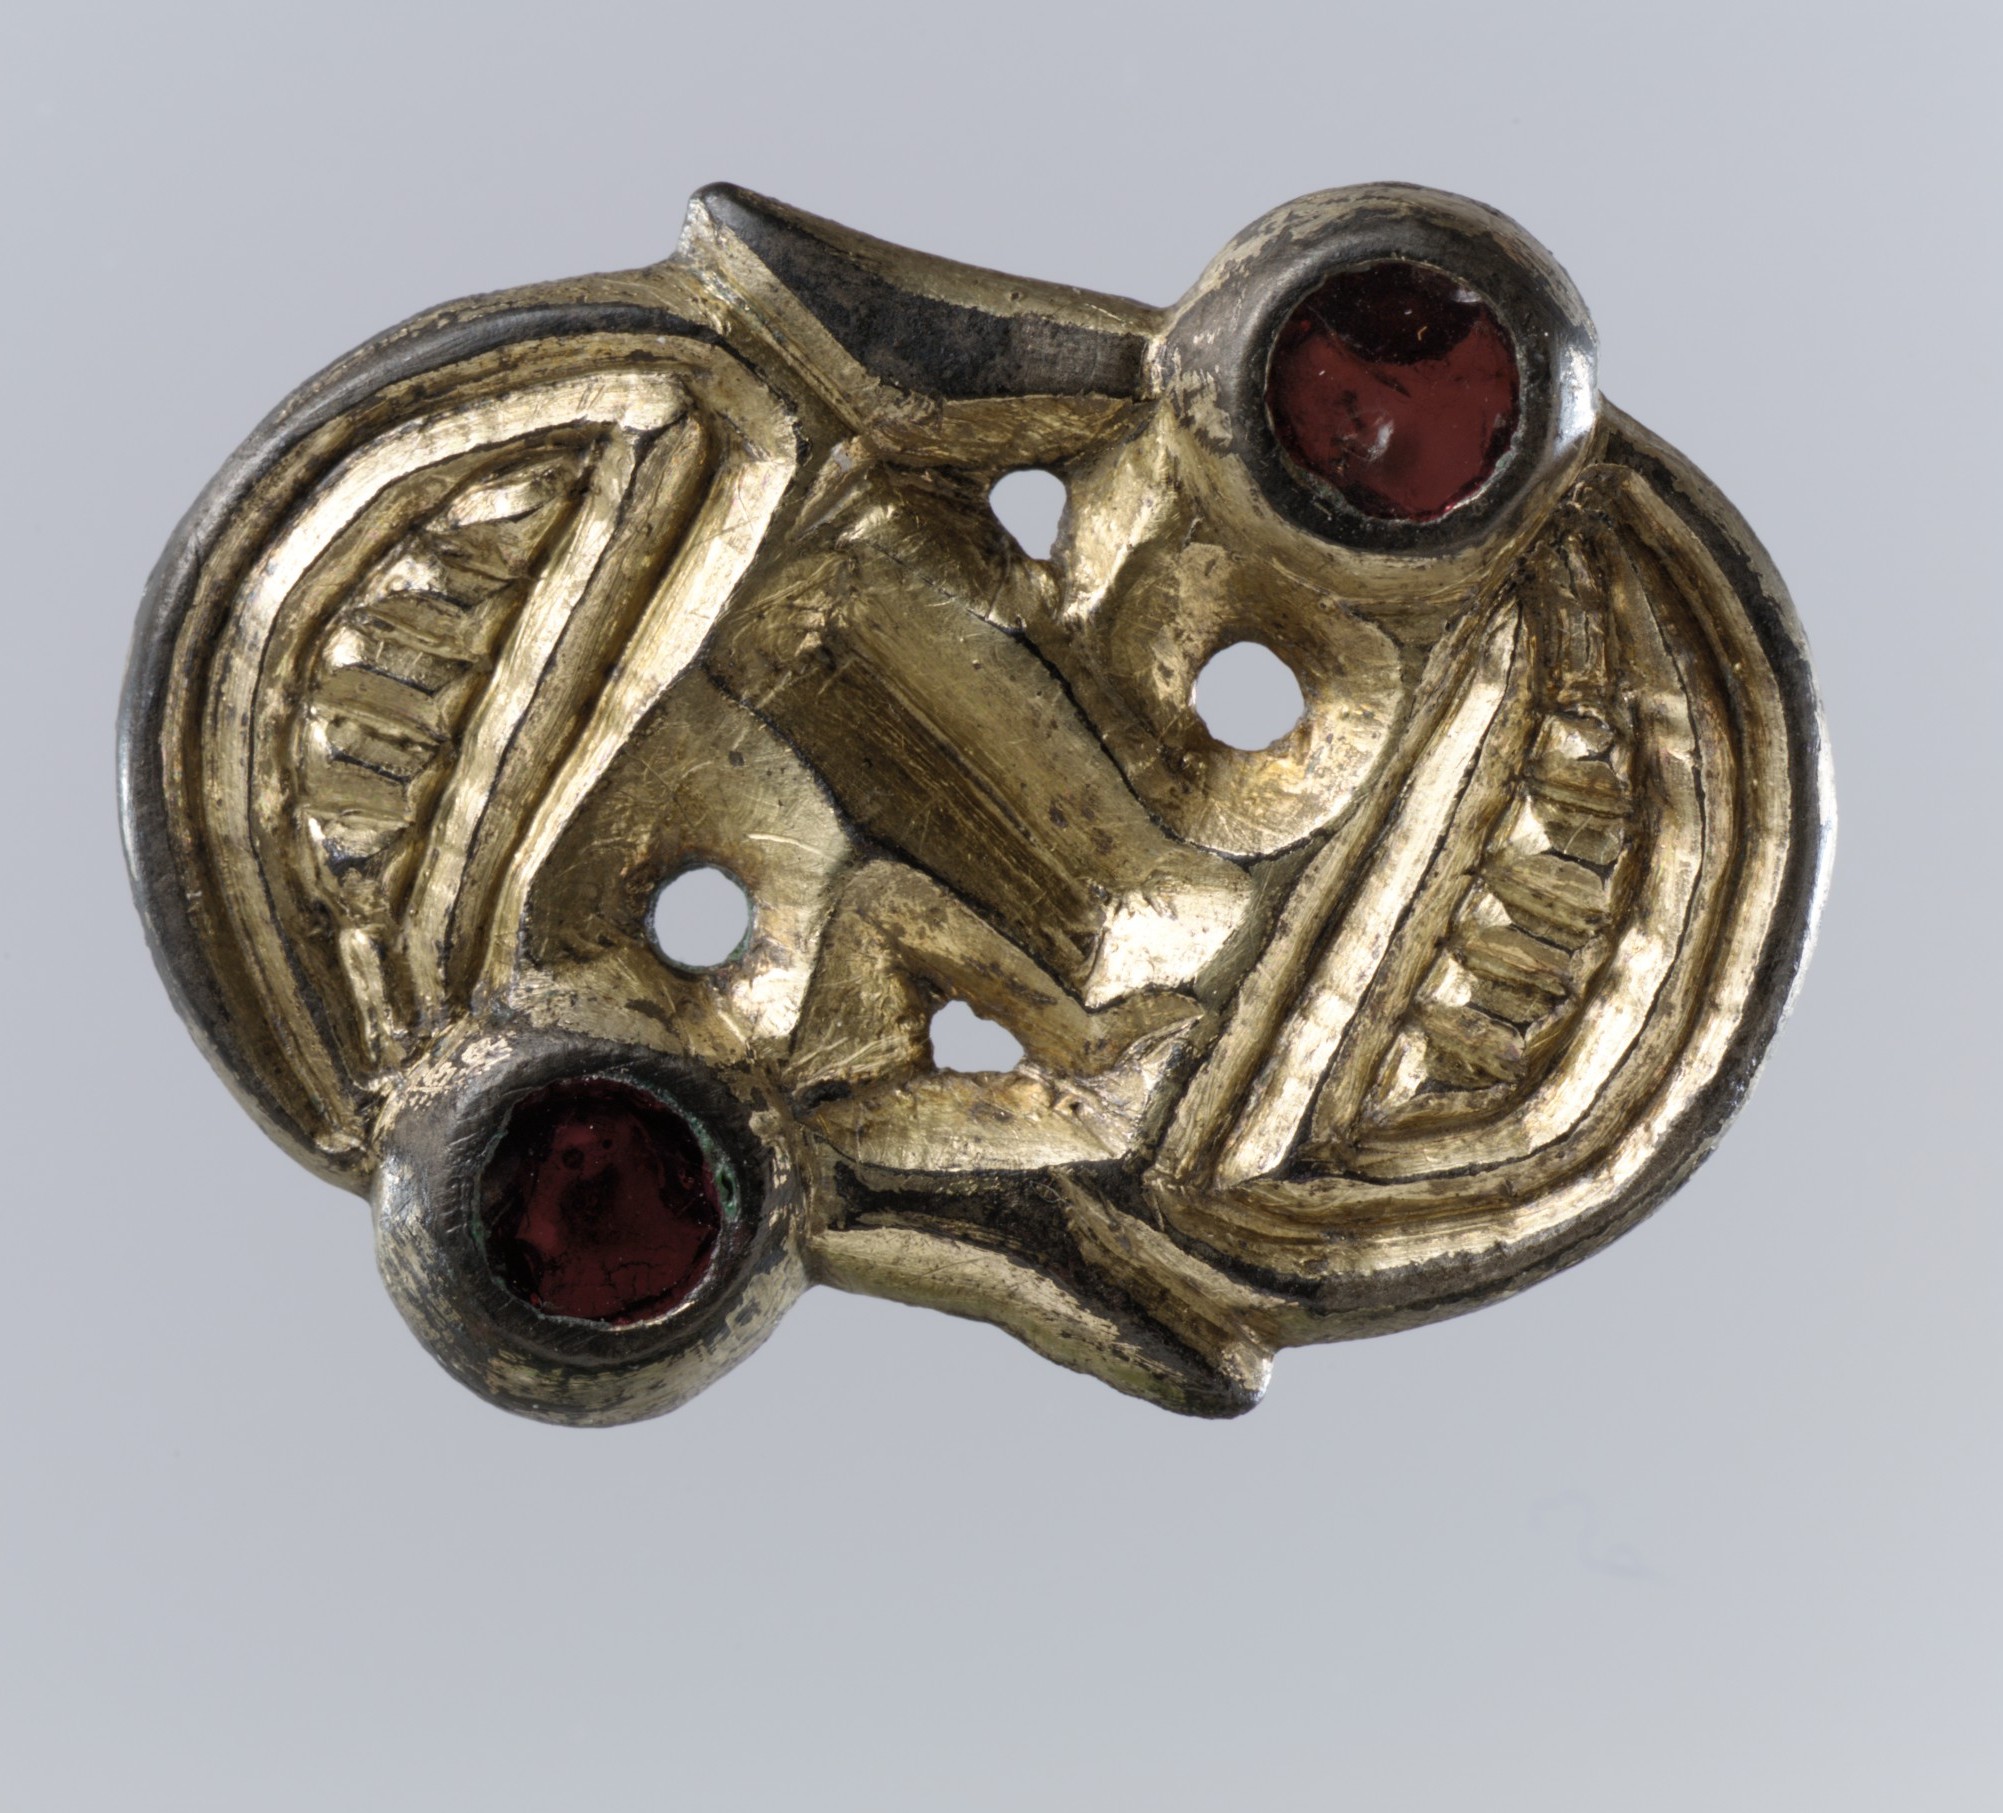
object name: brooch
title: S-Shaped Brooch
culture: frankish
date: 534-566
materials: garnet, silver gilt